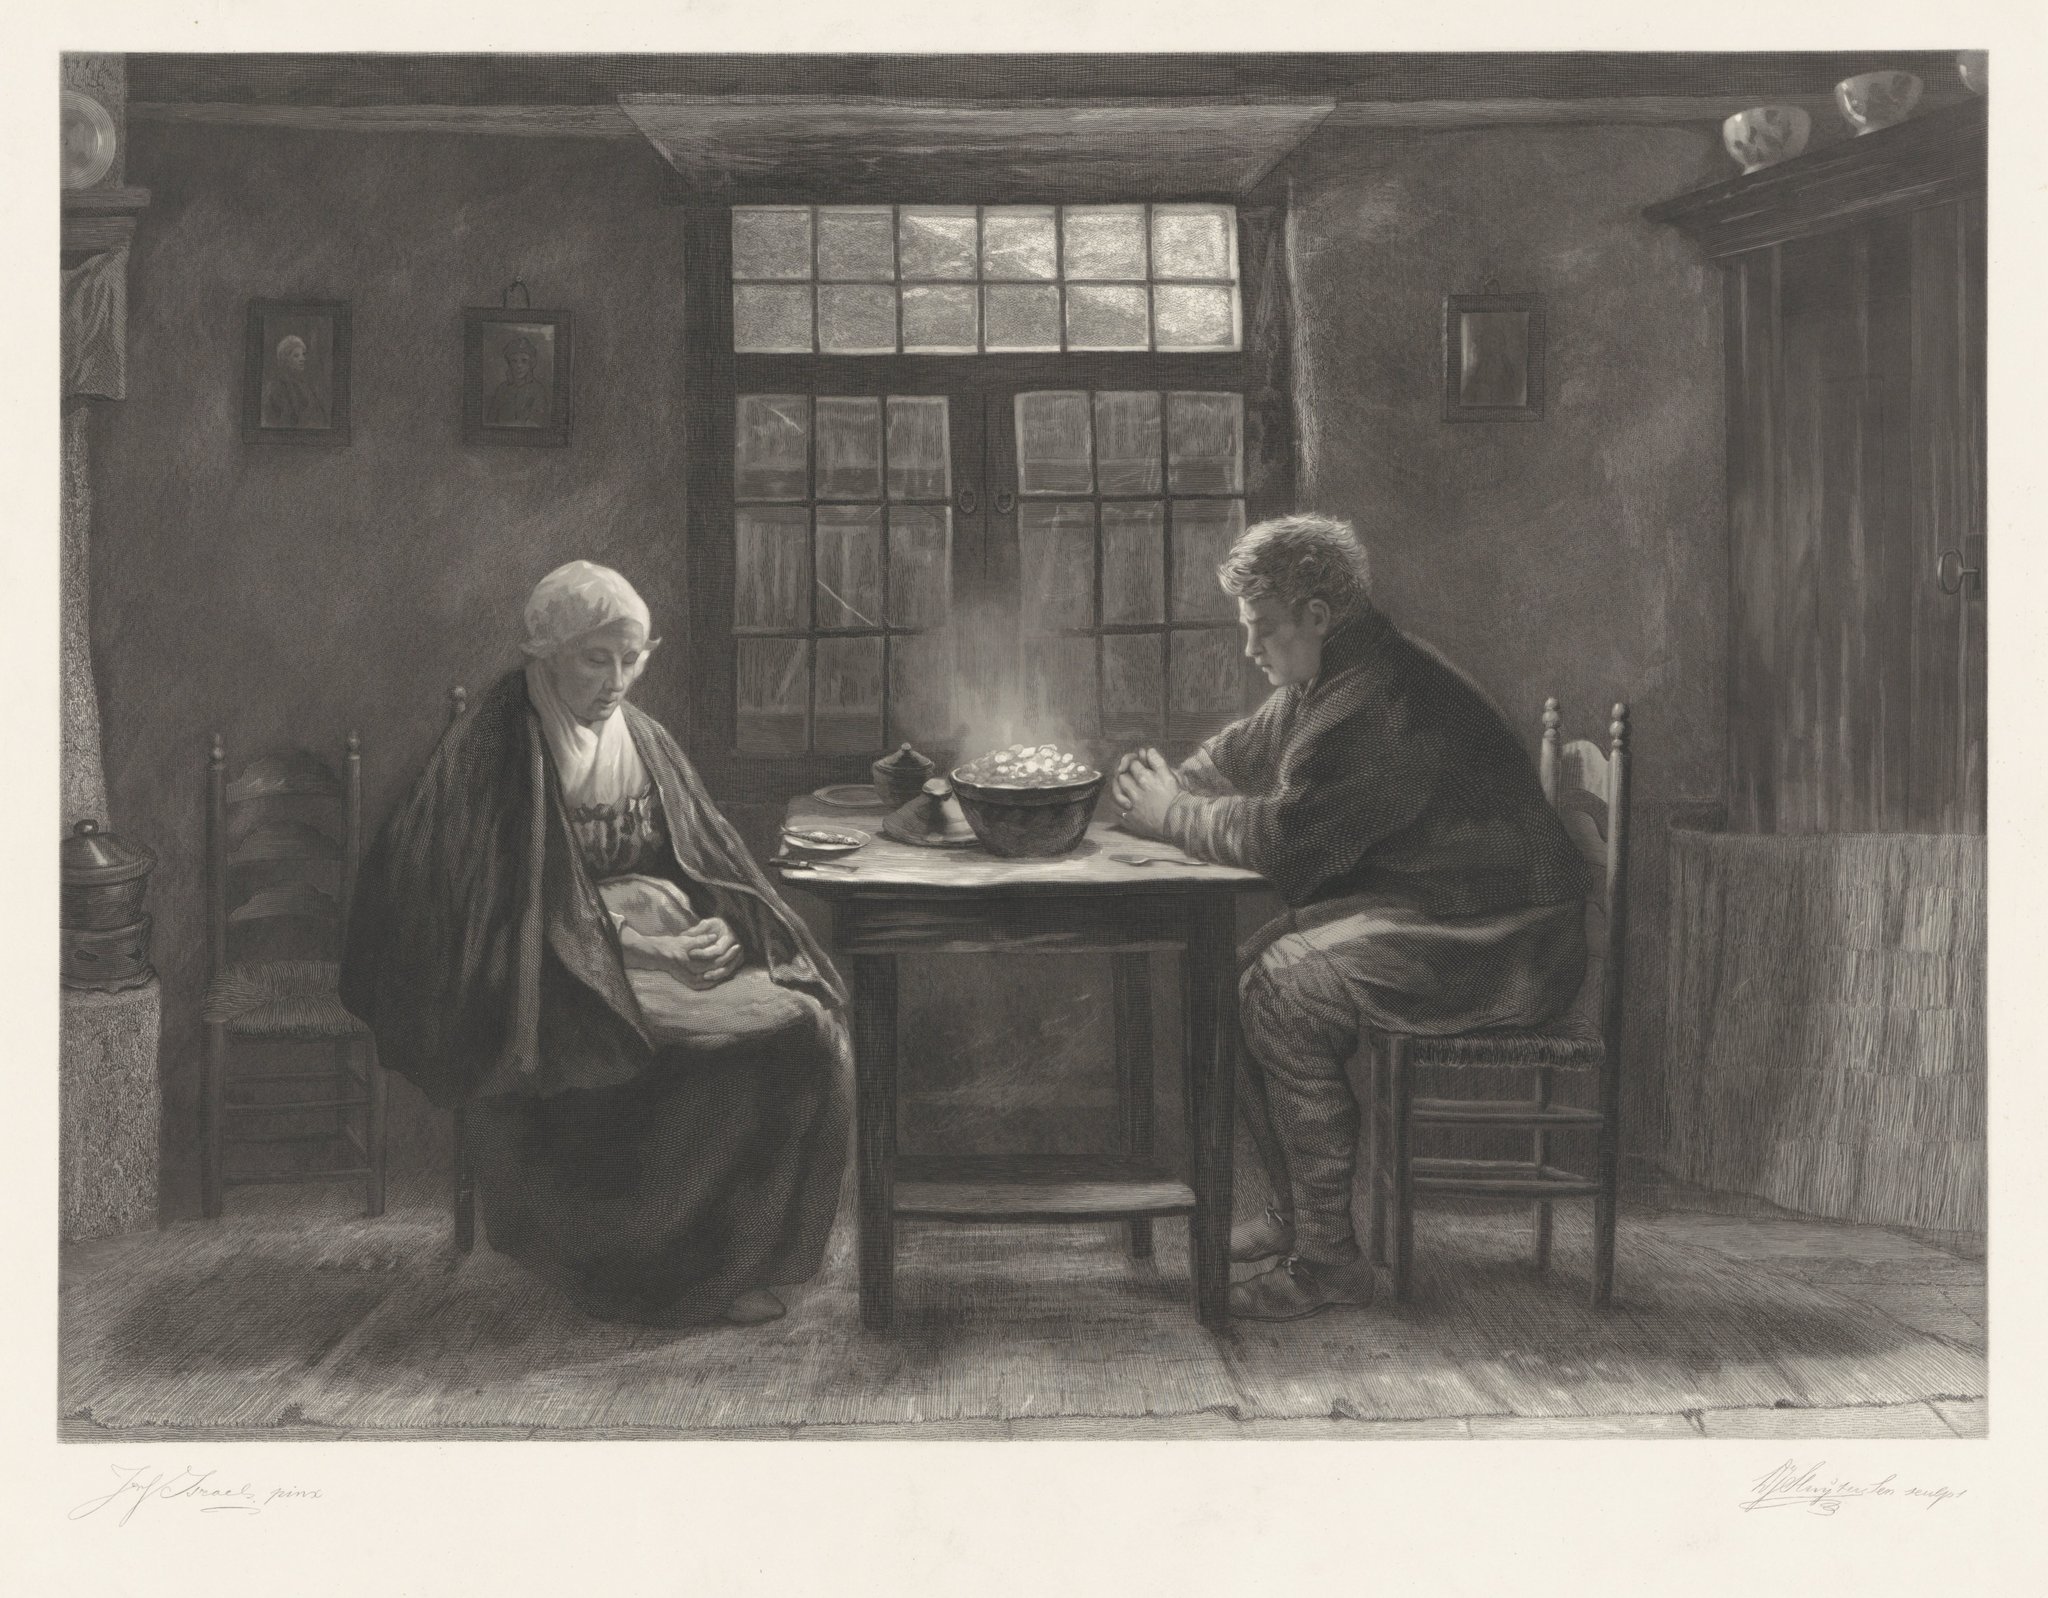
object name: print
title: Prayer before the Meal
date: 1880-1886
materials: paper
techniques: aquatint, engraving, etching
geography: amsterdam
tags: bony fishes: herring, prayer at table, saying grace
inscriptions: collector's mark: Lugt 2228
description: Een jonge man en een oude vrouw in een eenvoudig interieur zitten te bidden voor het eten. Op tafel staat een dampende kom met eten. Op een bordje ligt een haring.